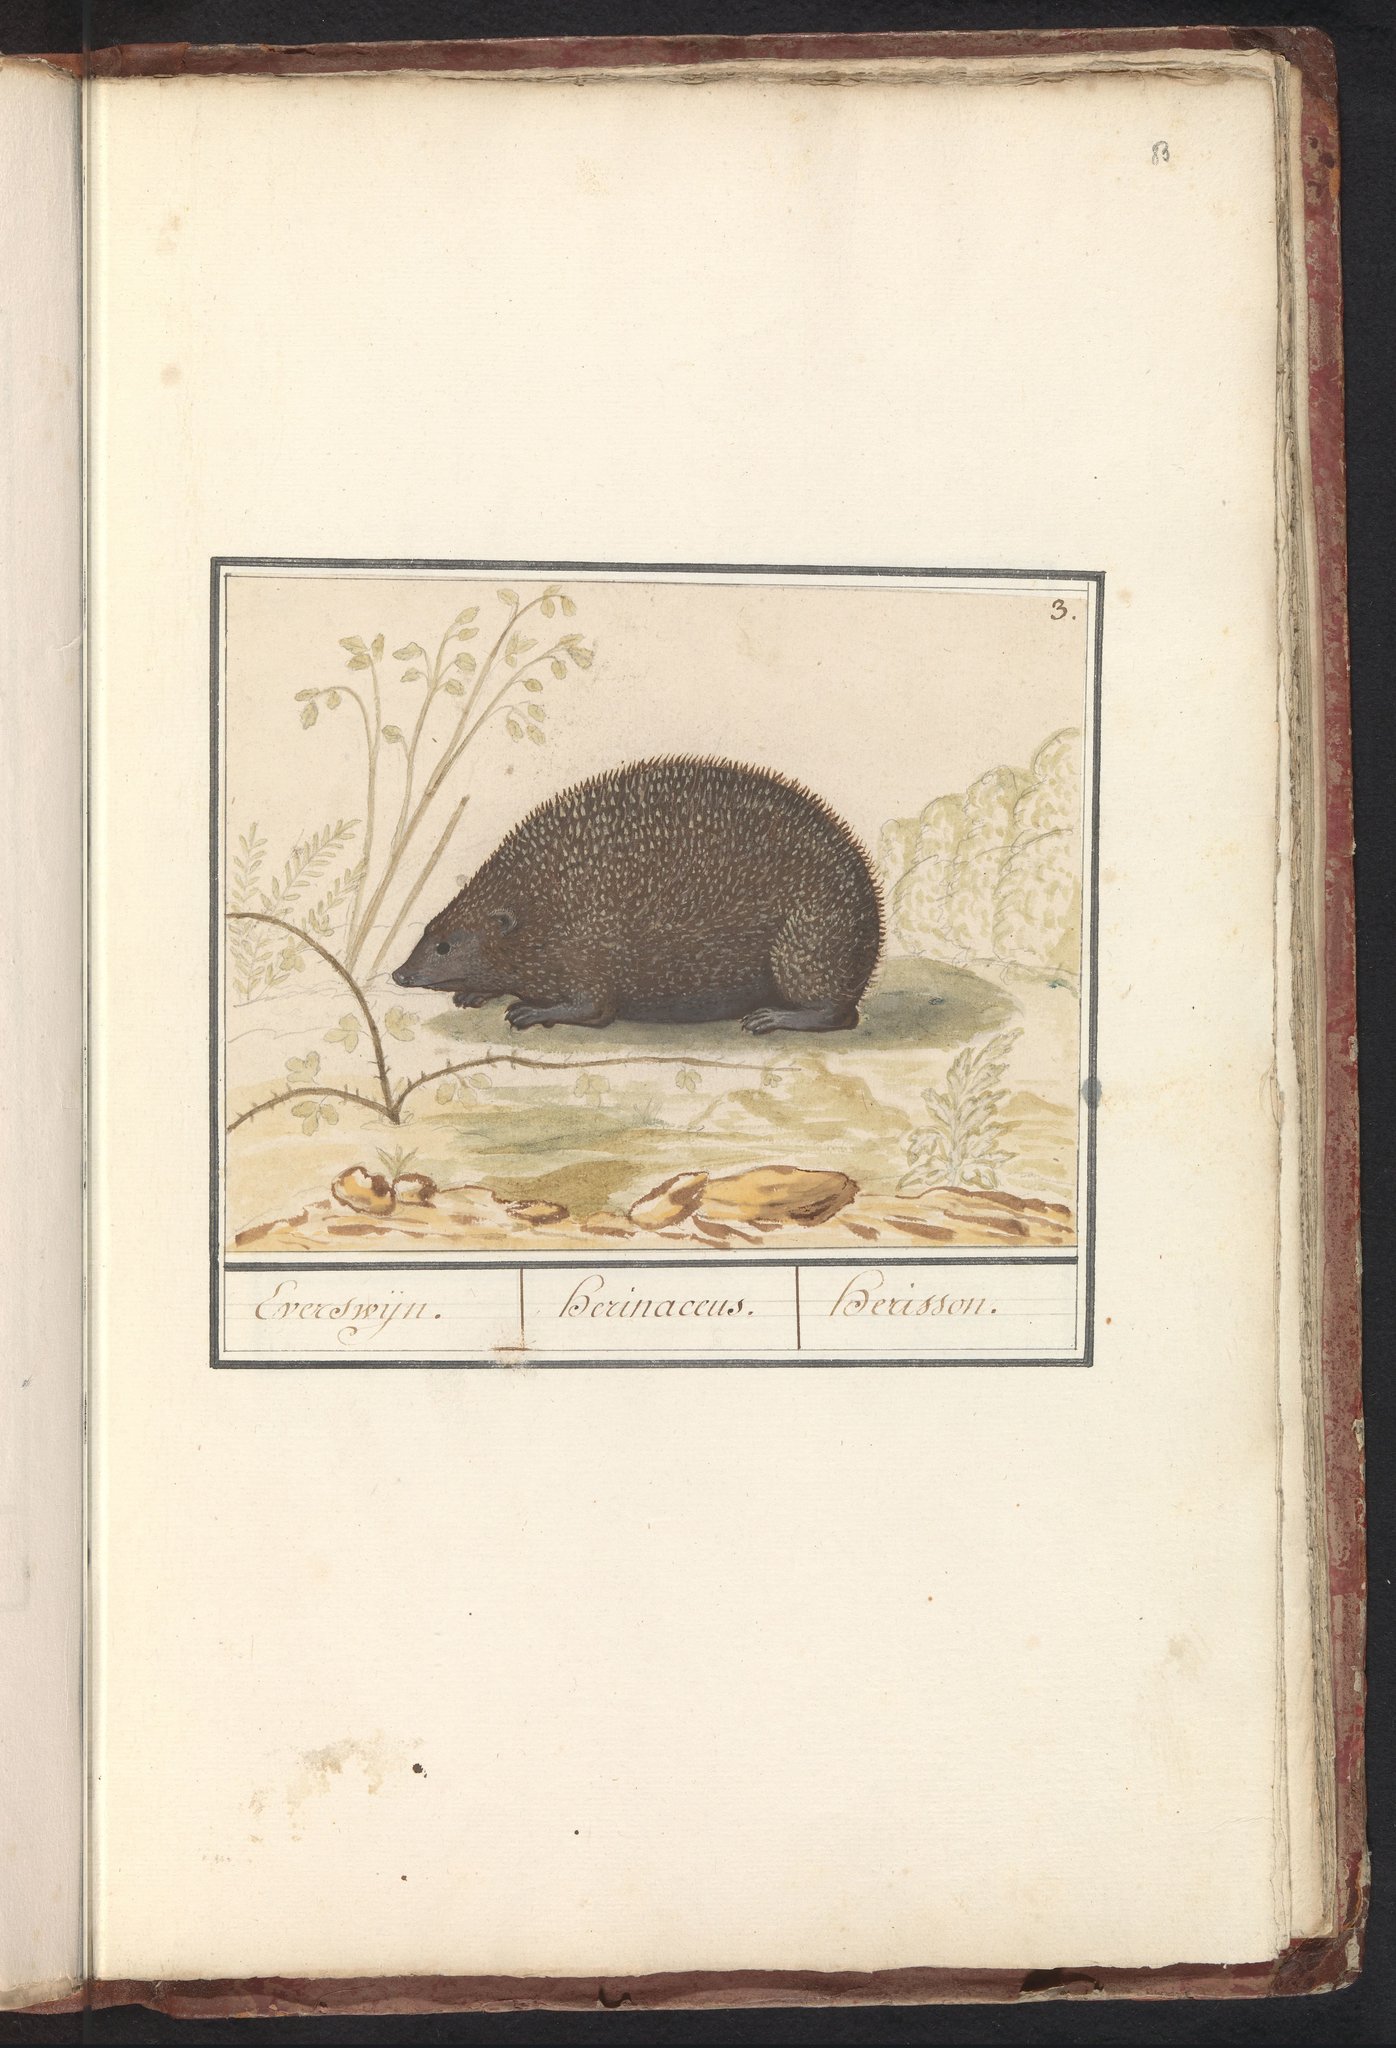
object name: drawing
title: Egel (Erinaceus europaeus)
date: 1596-1610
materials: paint, paper, pencil, watercolor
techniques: brush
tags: other mammals: hedgehog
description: Egel. Rechtsboven genummerd: 3. Onderdeel van het eerste album met tekeningen van viervoeters. Eerste van twaalf albums met tekeningen van dieren, vogels en planten bekend rond 1600, gemaakt in opdracht van keizer Rudolf II. Met toelichting in Nederlands, Latijn en Frans.